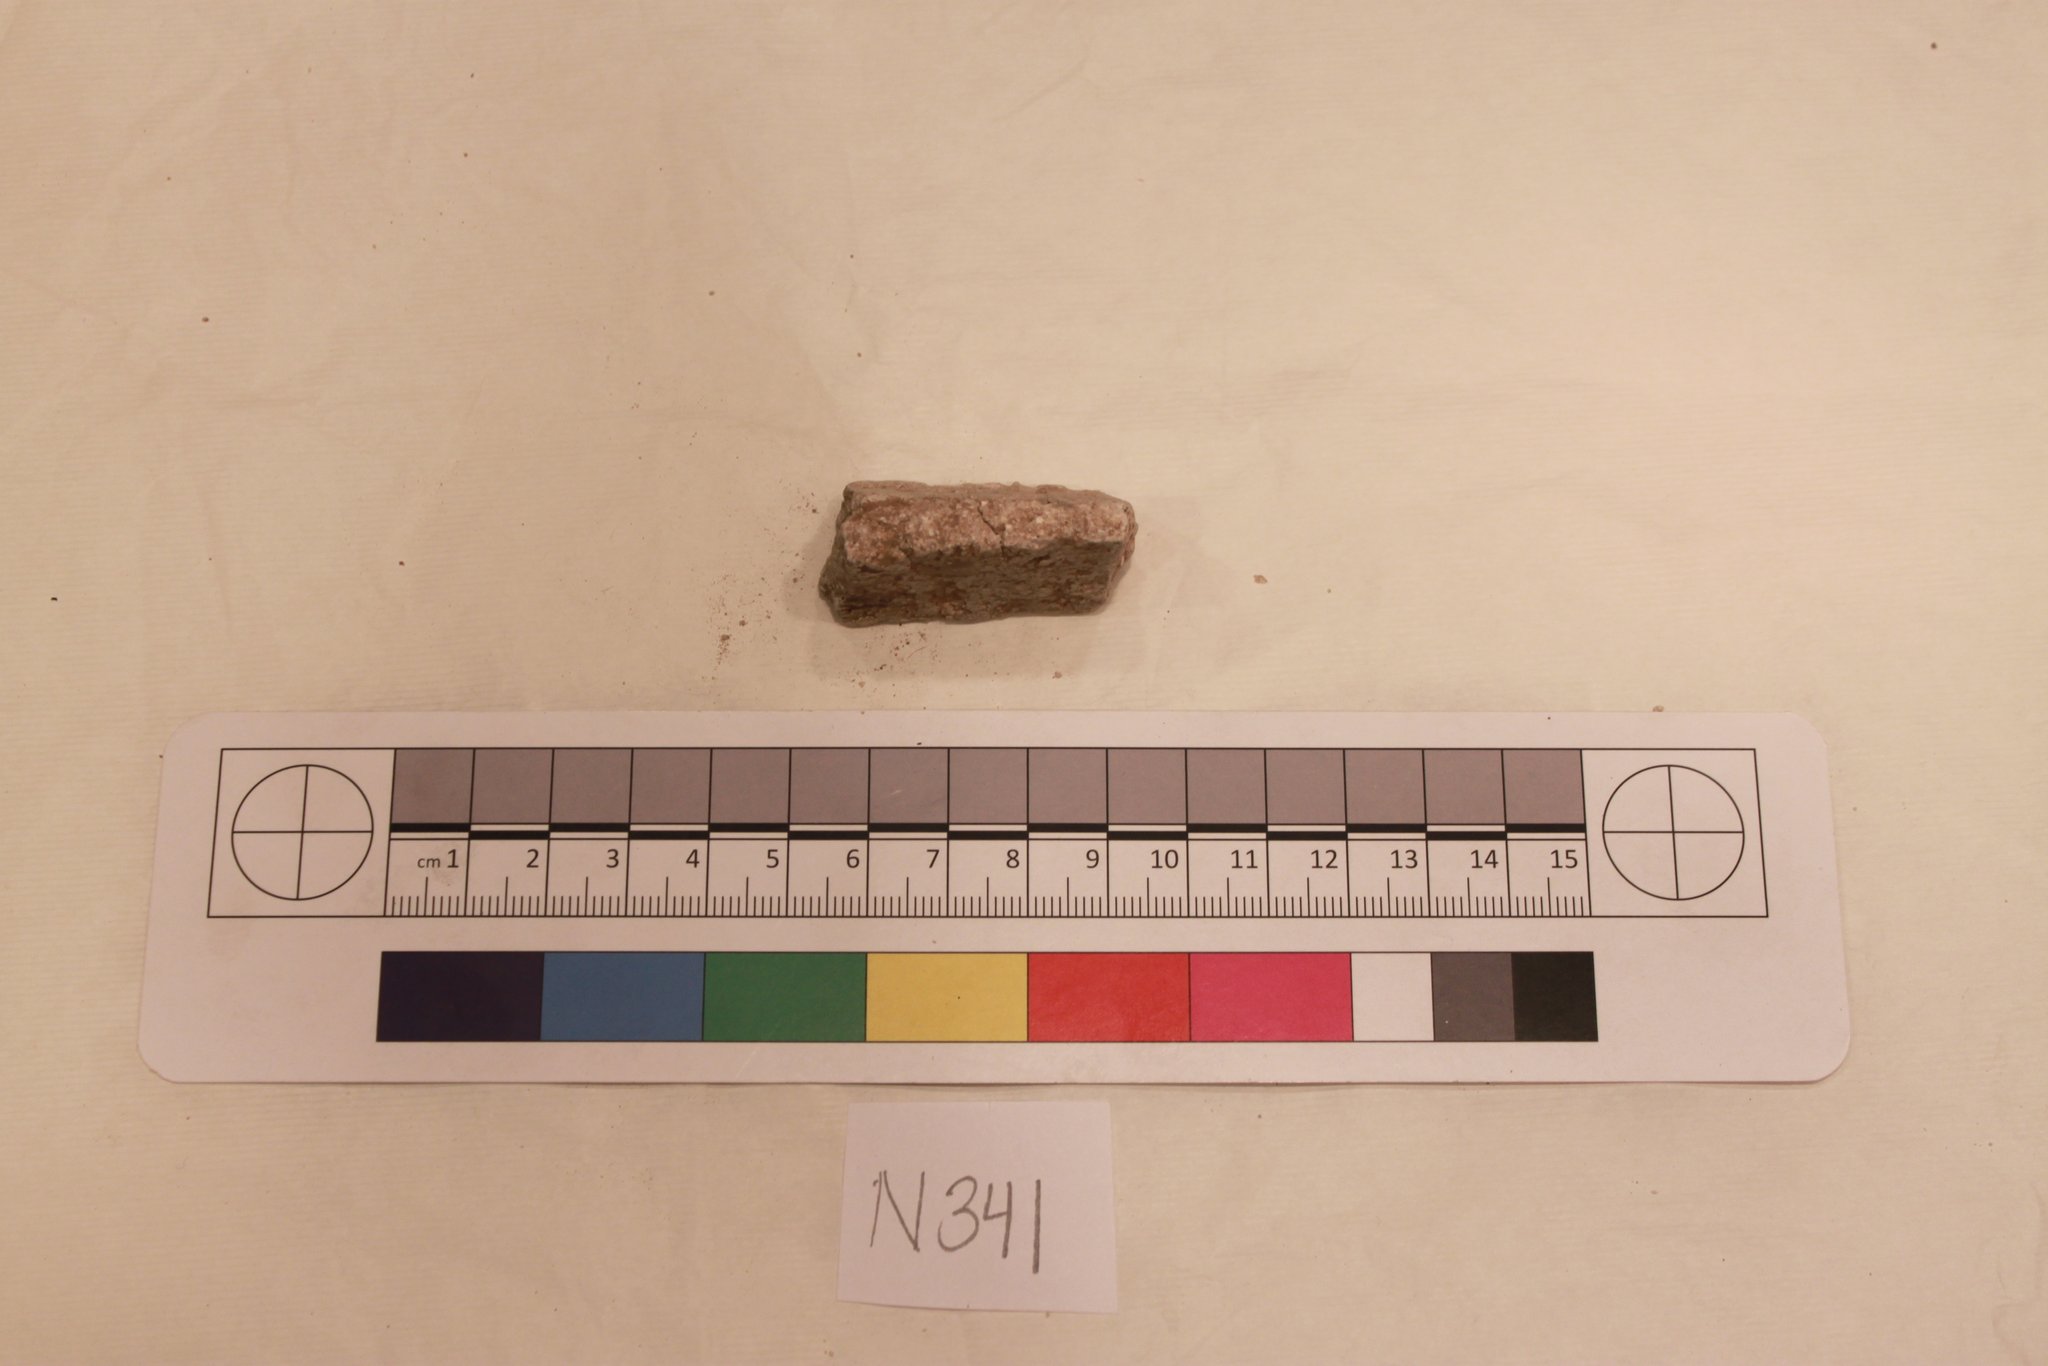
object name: fragment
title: Stucco Fragment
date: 701-1200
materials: plaster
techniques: carving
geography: iran